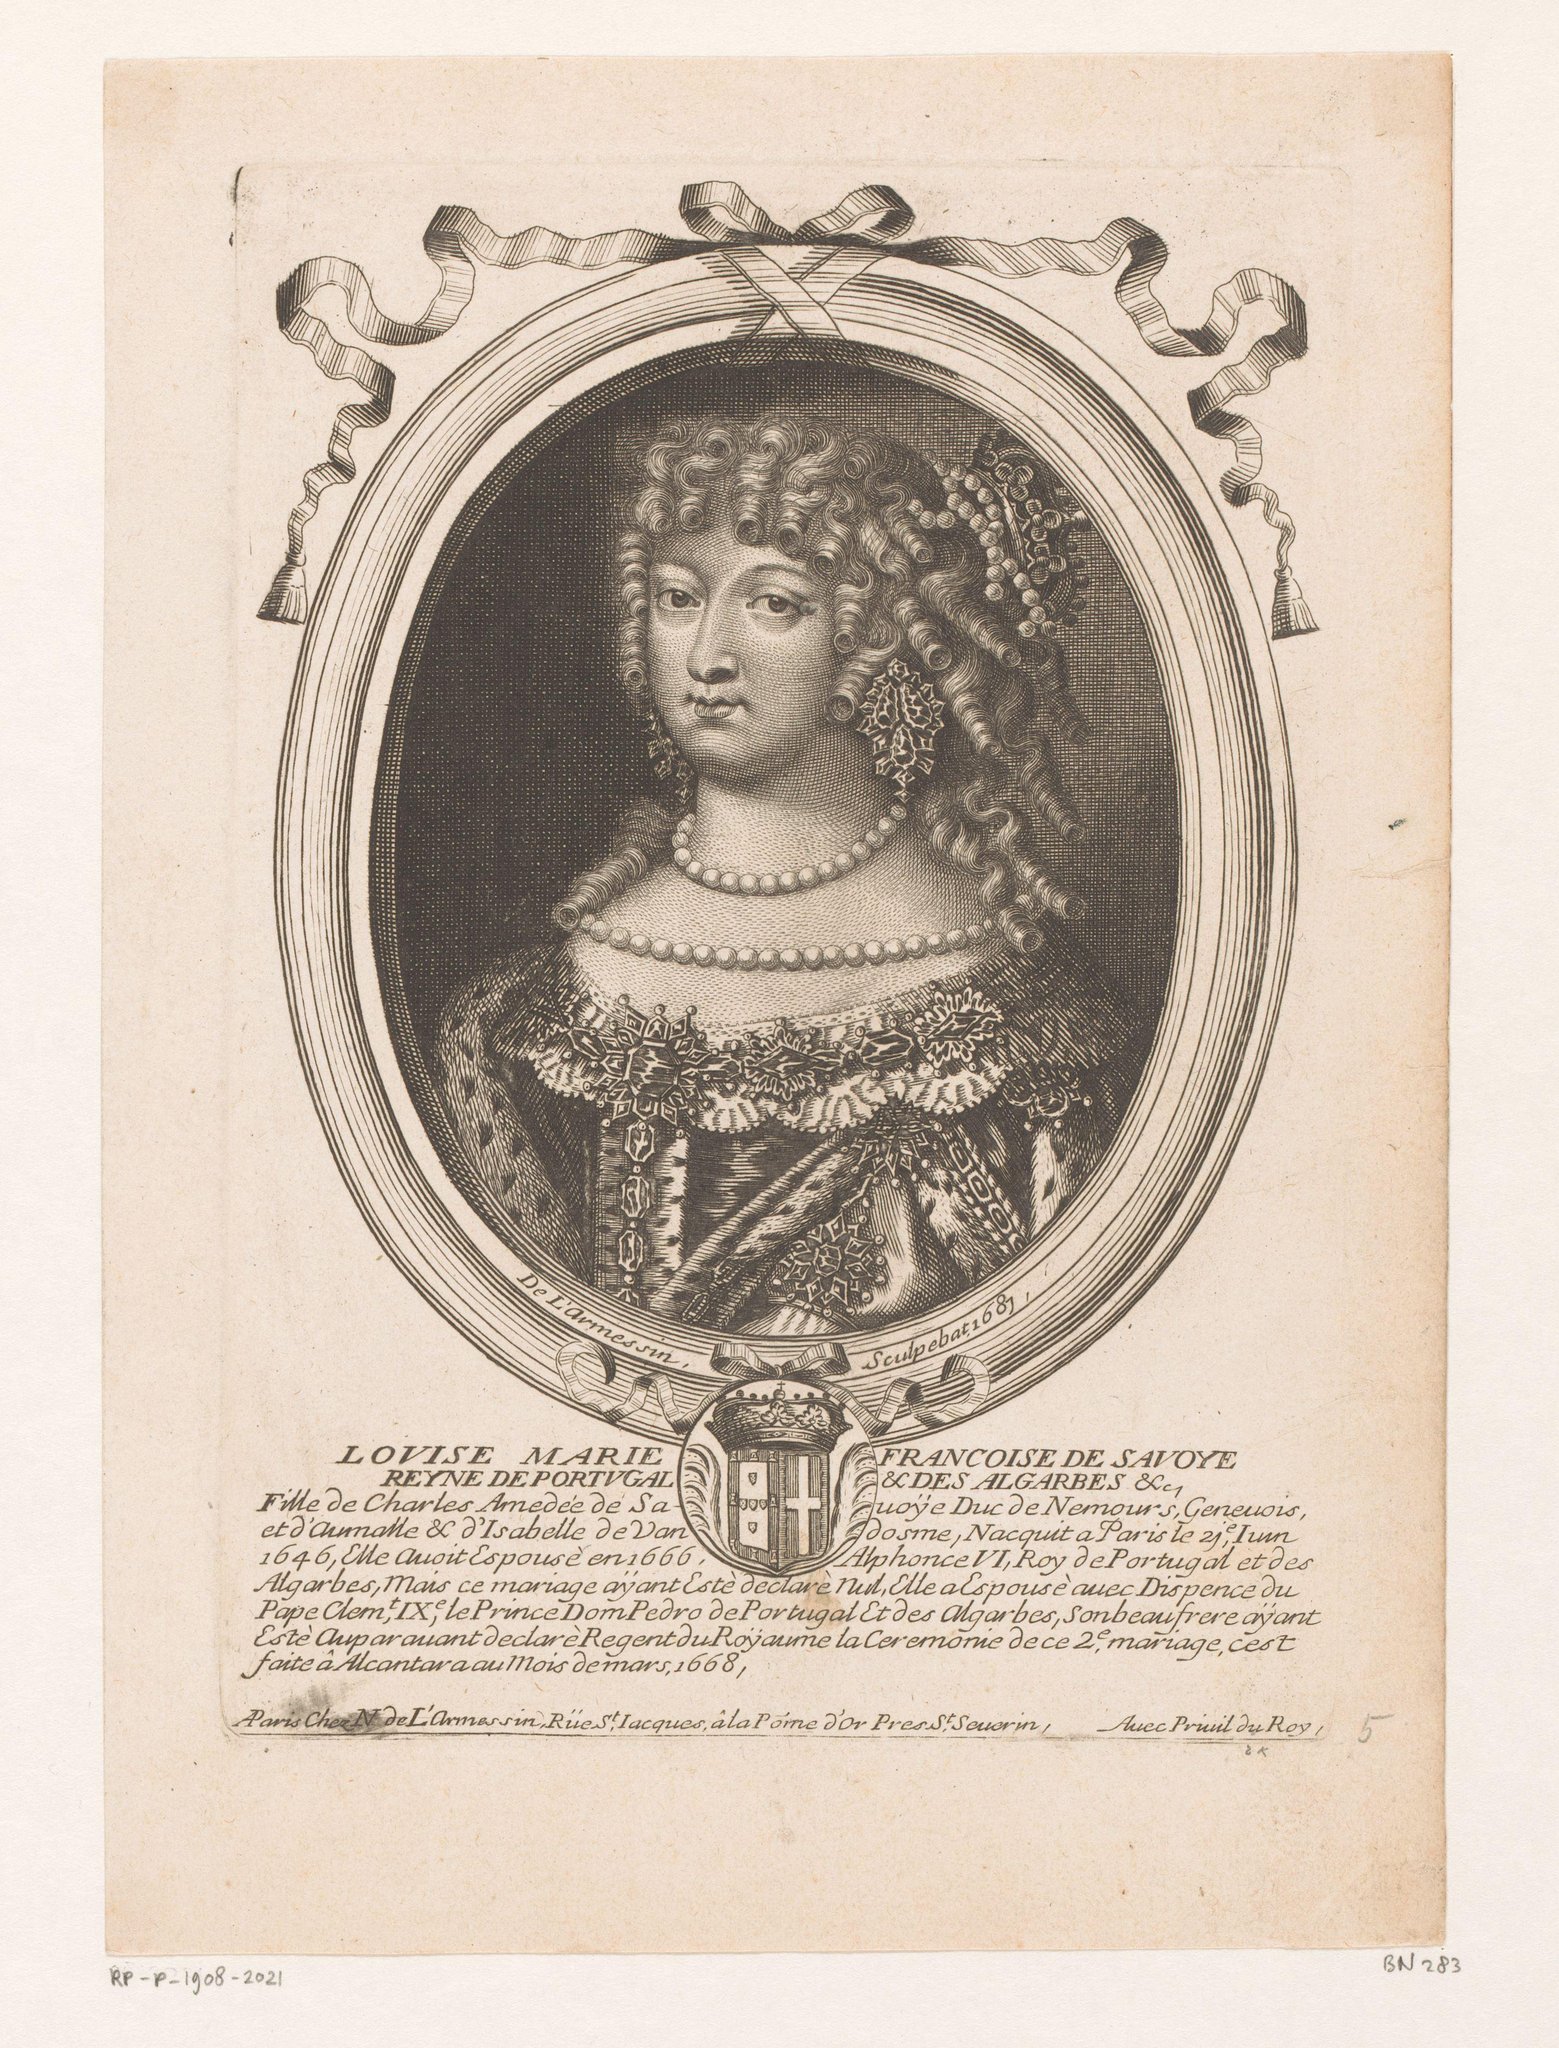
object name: print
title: Portret van Maria Francisca Nemours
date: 1681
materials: paper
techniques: engraving, etching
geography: france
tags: paris, historical persons, queen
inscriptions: collector's mark: Lugt 2228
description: Maakt deel uit van een grootschalige serie met portretten van prominente figuren. Binnen de serie bevindt zich een sectie getiteld 'Les Augustes Représentations De tous les Roys De France depuis Pharamond Iusqu'à Louys XIIII'. De serie werd respectievelijk uitgegeven door Pierre Bertrand, door zijn weduwe en door De Larmessin zelf.